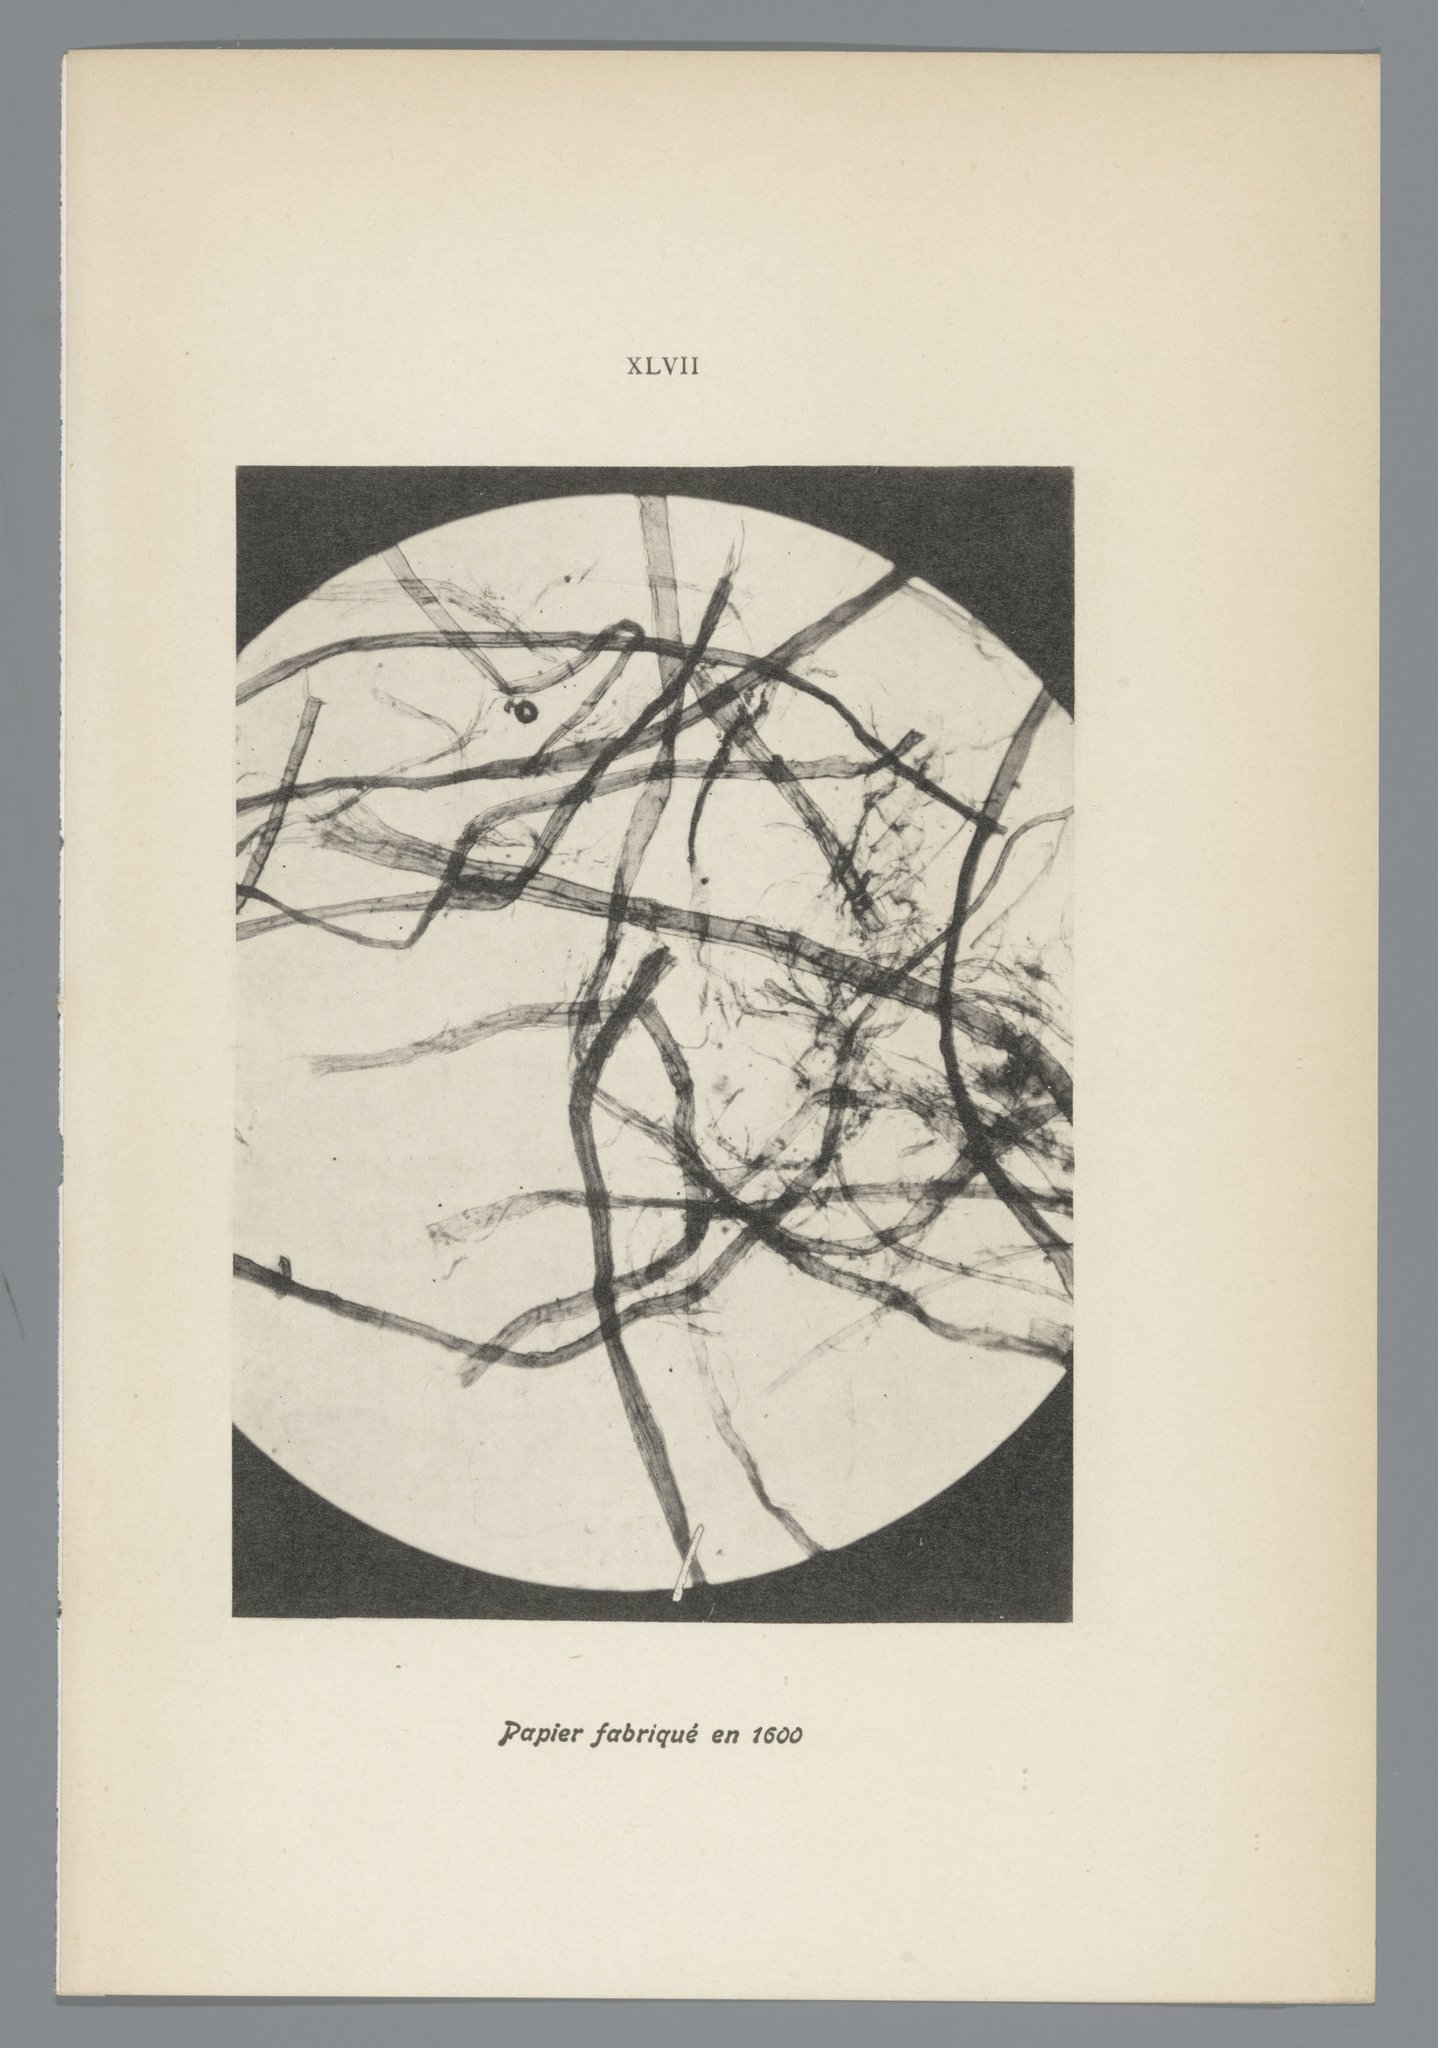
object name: photograph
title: Photomicrographs of Paper Fibres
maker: Anonymous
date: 1900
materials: ink, paper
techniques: photograph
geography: france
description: For science, photography was a useful tool for supplementing or refuting what could be observed with the human eye. The camera, after all, saw more than the eye, and the photographic plate had a better ‘memory’ than man. By combining a microscope and a camera, tiny objects could also be studied closely.